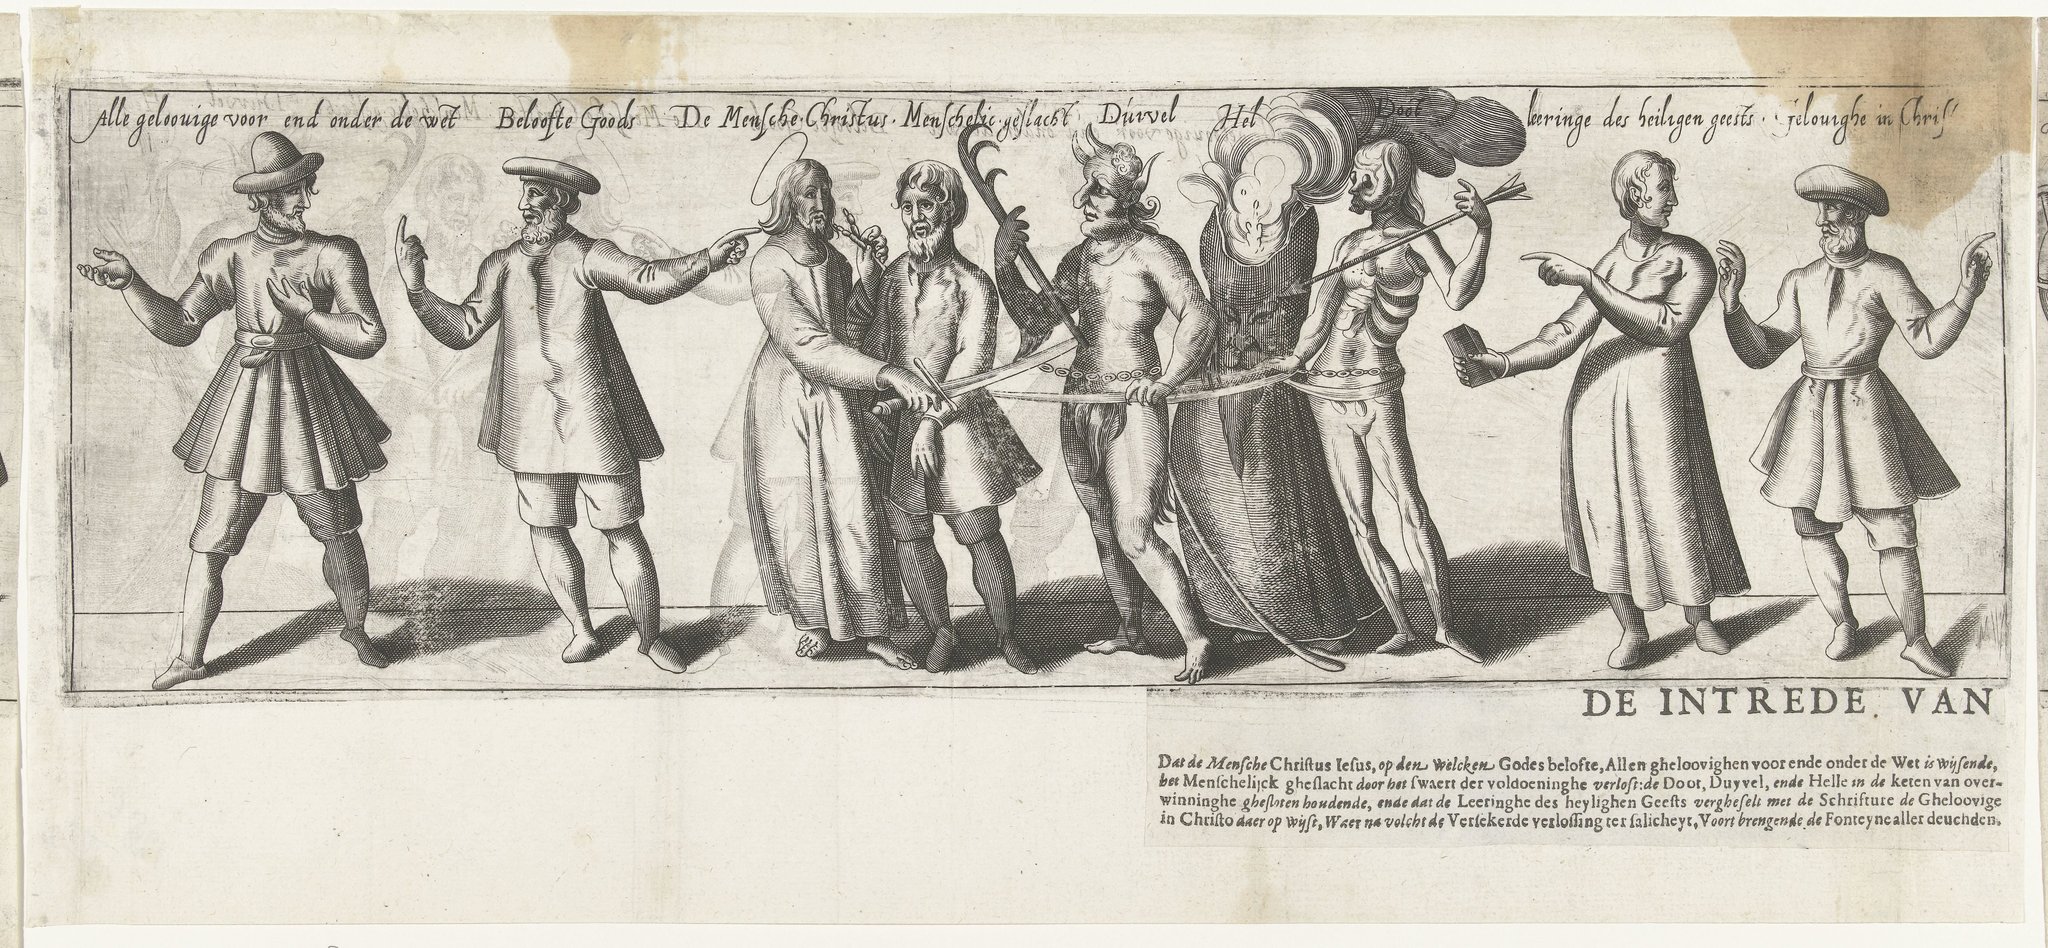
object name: print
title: De intrede van Aedwaertswoude verthoont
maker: Anonymous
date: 1607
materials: paper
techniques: engraving, letterpress printing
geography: northern netherlands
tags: chamber of rhetoric (dutch: 'rederijkerskamer'), festivities (+ parade, pageant, cavalcade ~ festive activities), haarlem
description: Gebruikt als illustratie in: Const-thoonende ivweel, by de loflijcke stadt Haerlem, ten versoecke van Trou moet blijcken, in't licht gebracht. : Waer inne duydelick verclaert ende verthoont wordt alles wat den mensche mach wecken om den armen te troosten, ende zijnen naesten by te staen. : In twaelf spelen van sinne ... in redenrijck naar de volgende voorgegevene caerte van 't speel-korenken, Zacharias Heyns, Zwolle 1607. Los fragment, bedoeld om samen met de andere delen tot een fries gemonteerd te worden.